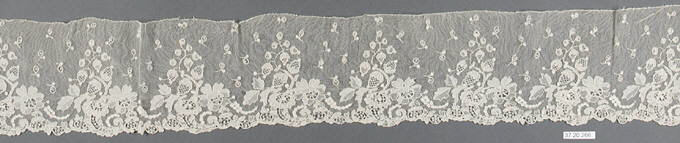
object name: border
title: Border (one of three)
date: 1801-1900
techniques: lace